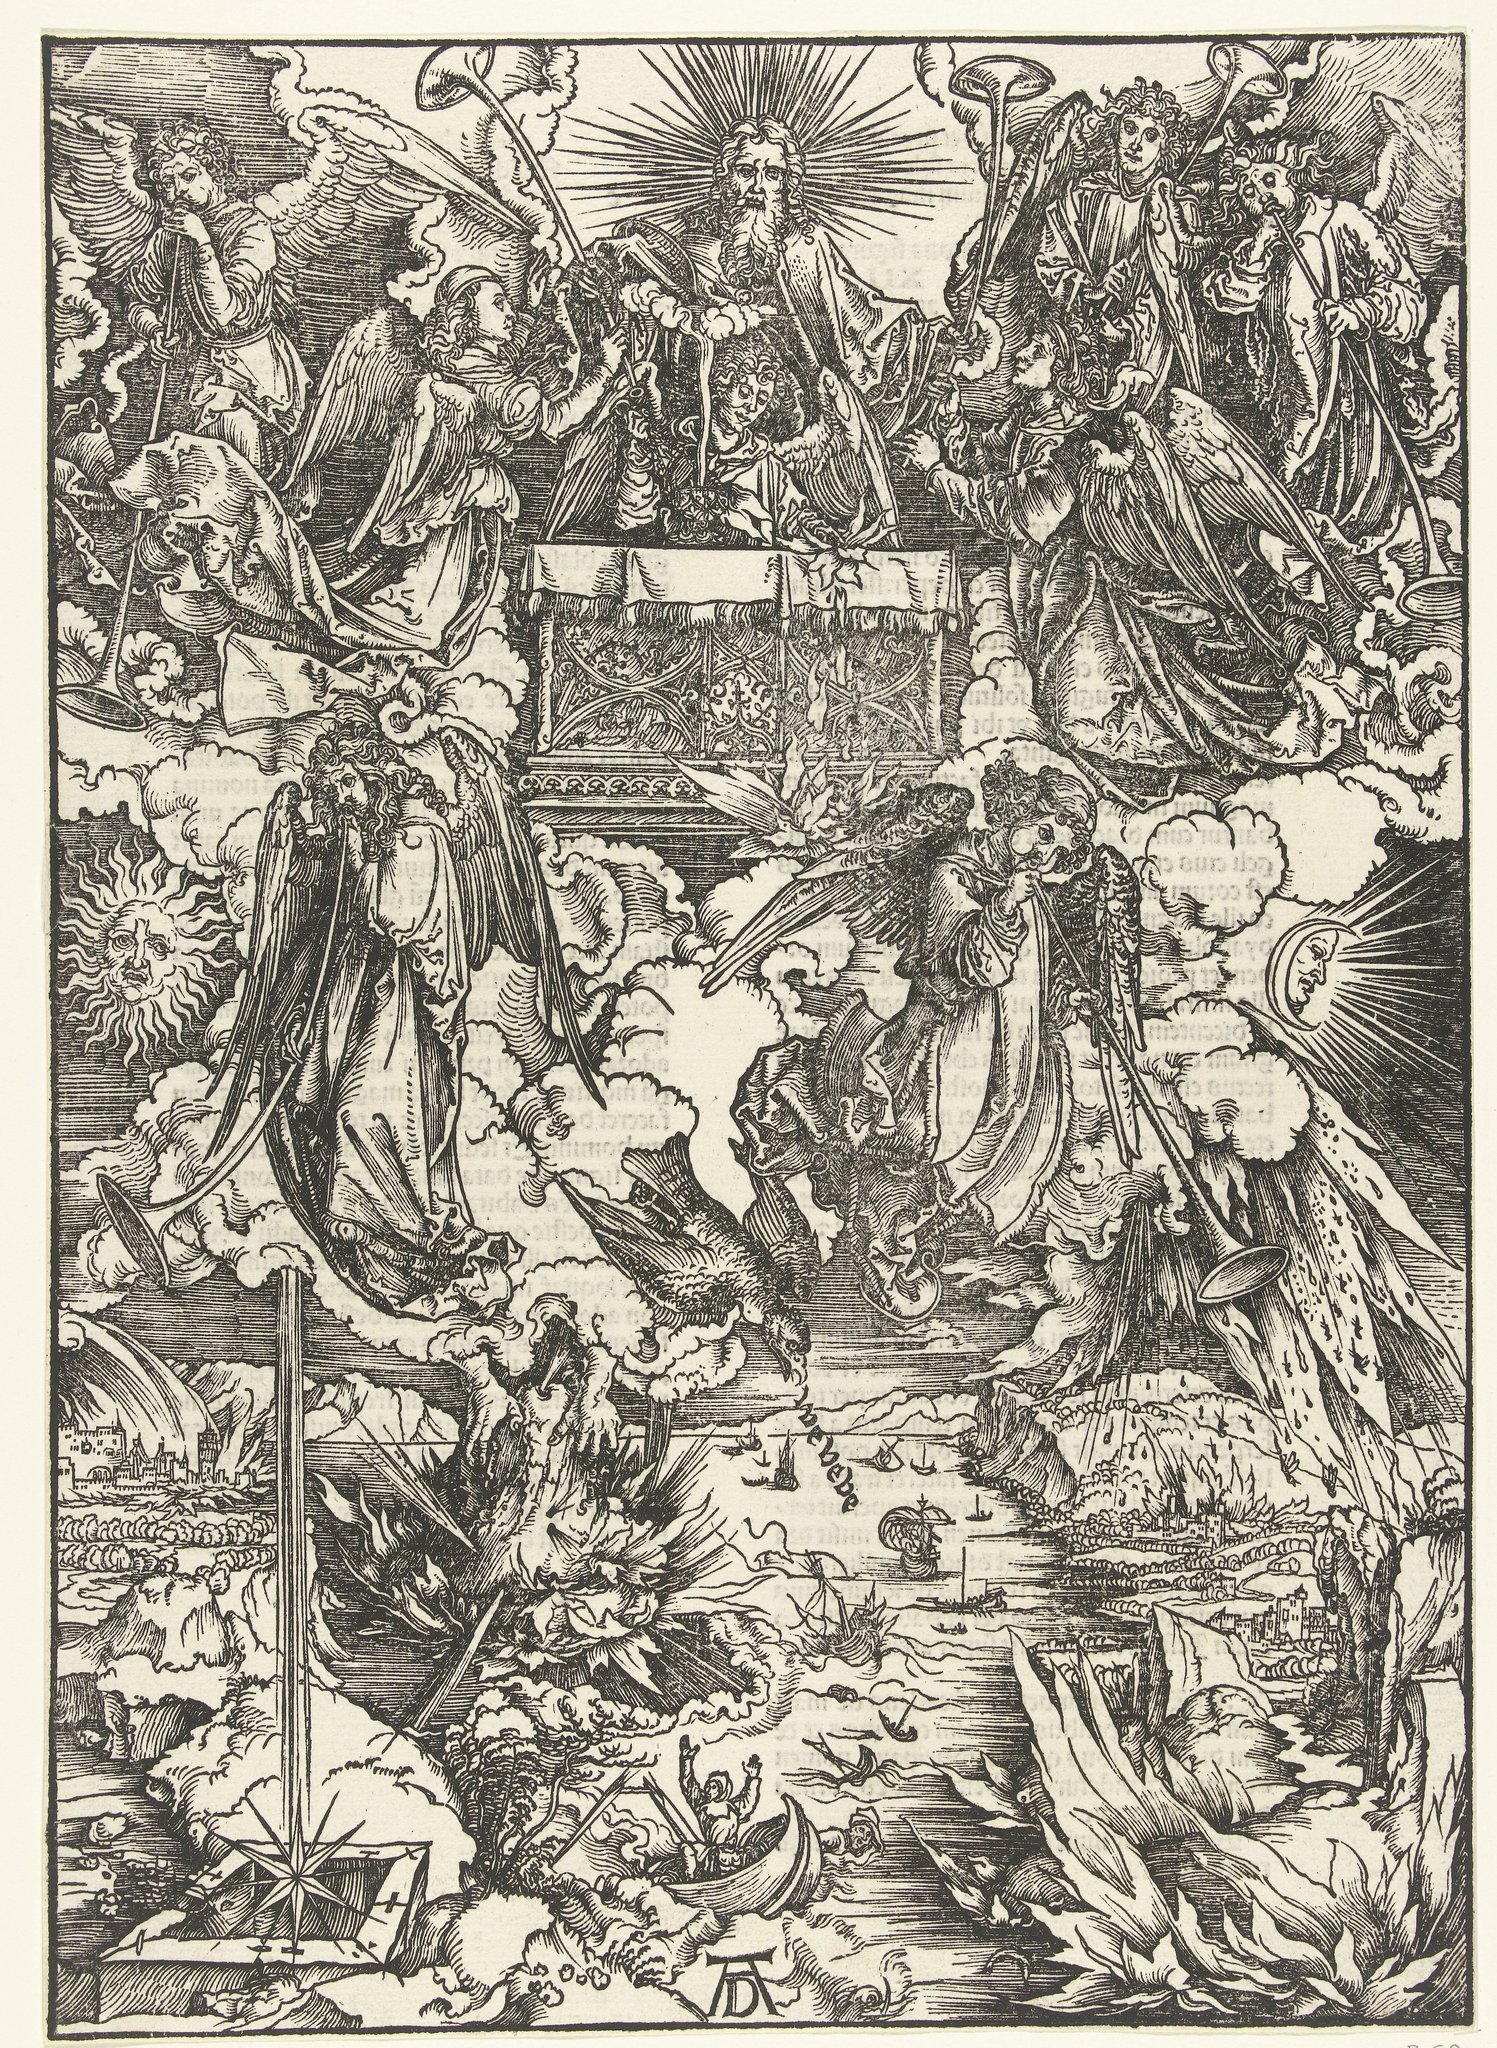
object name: print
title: De zeven engelen met de bazuinen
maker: albrecht dürer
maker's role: draughtsman, painter, print maker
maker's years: 1471-1528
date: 1496-1497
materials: paper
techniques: letterpress printing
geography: nuremberg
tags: the seven angels with trumpets ~ revelation of john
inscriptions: collector's mark: Lugt 240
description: God overhandigt bazuinen aan zeven engelen in de hemel. Als zij erop blazen, komt er grote rampspoed over de aarde: steden staan in brand, schepen vergaan. Een adelaar weeklaagt over de aardbewoners met de woorden 'Ve ve ve'. Op versozijde Latijnse bijbeltekst in gotisch schrift in twee kolommen.